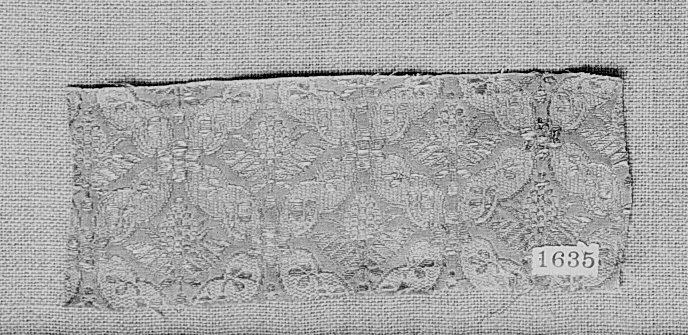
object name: piece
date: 1701-1800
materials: metal thread, silk